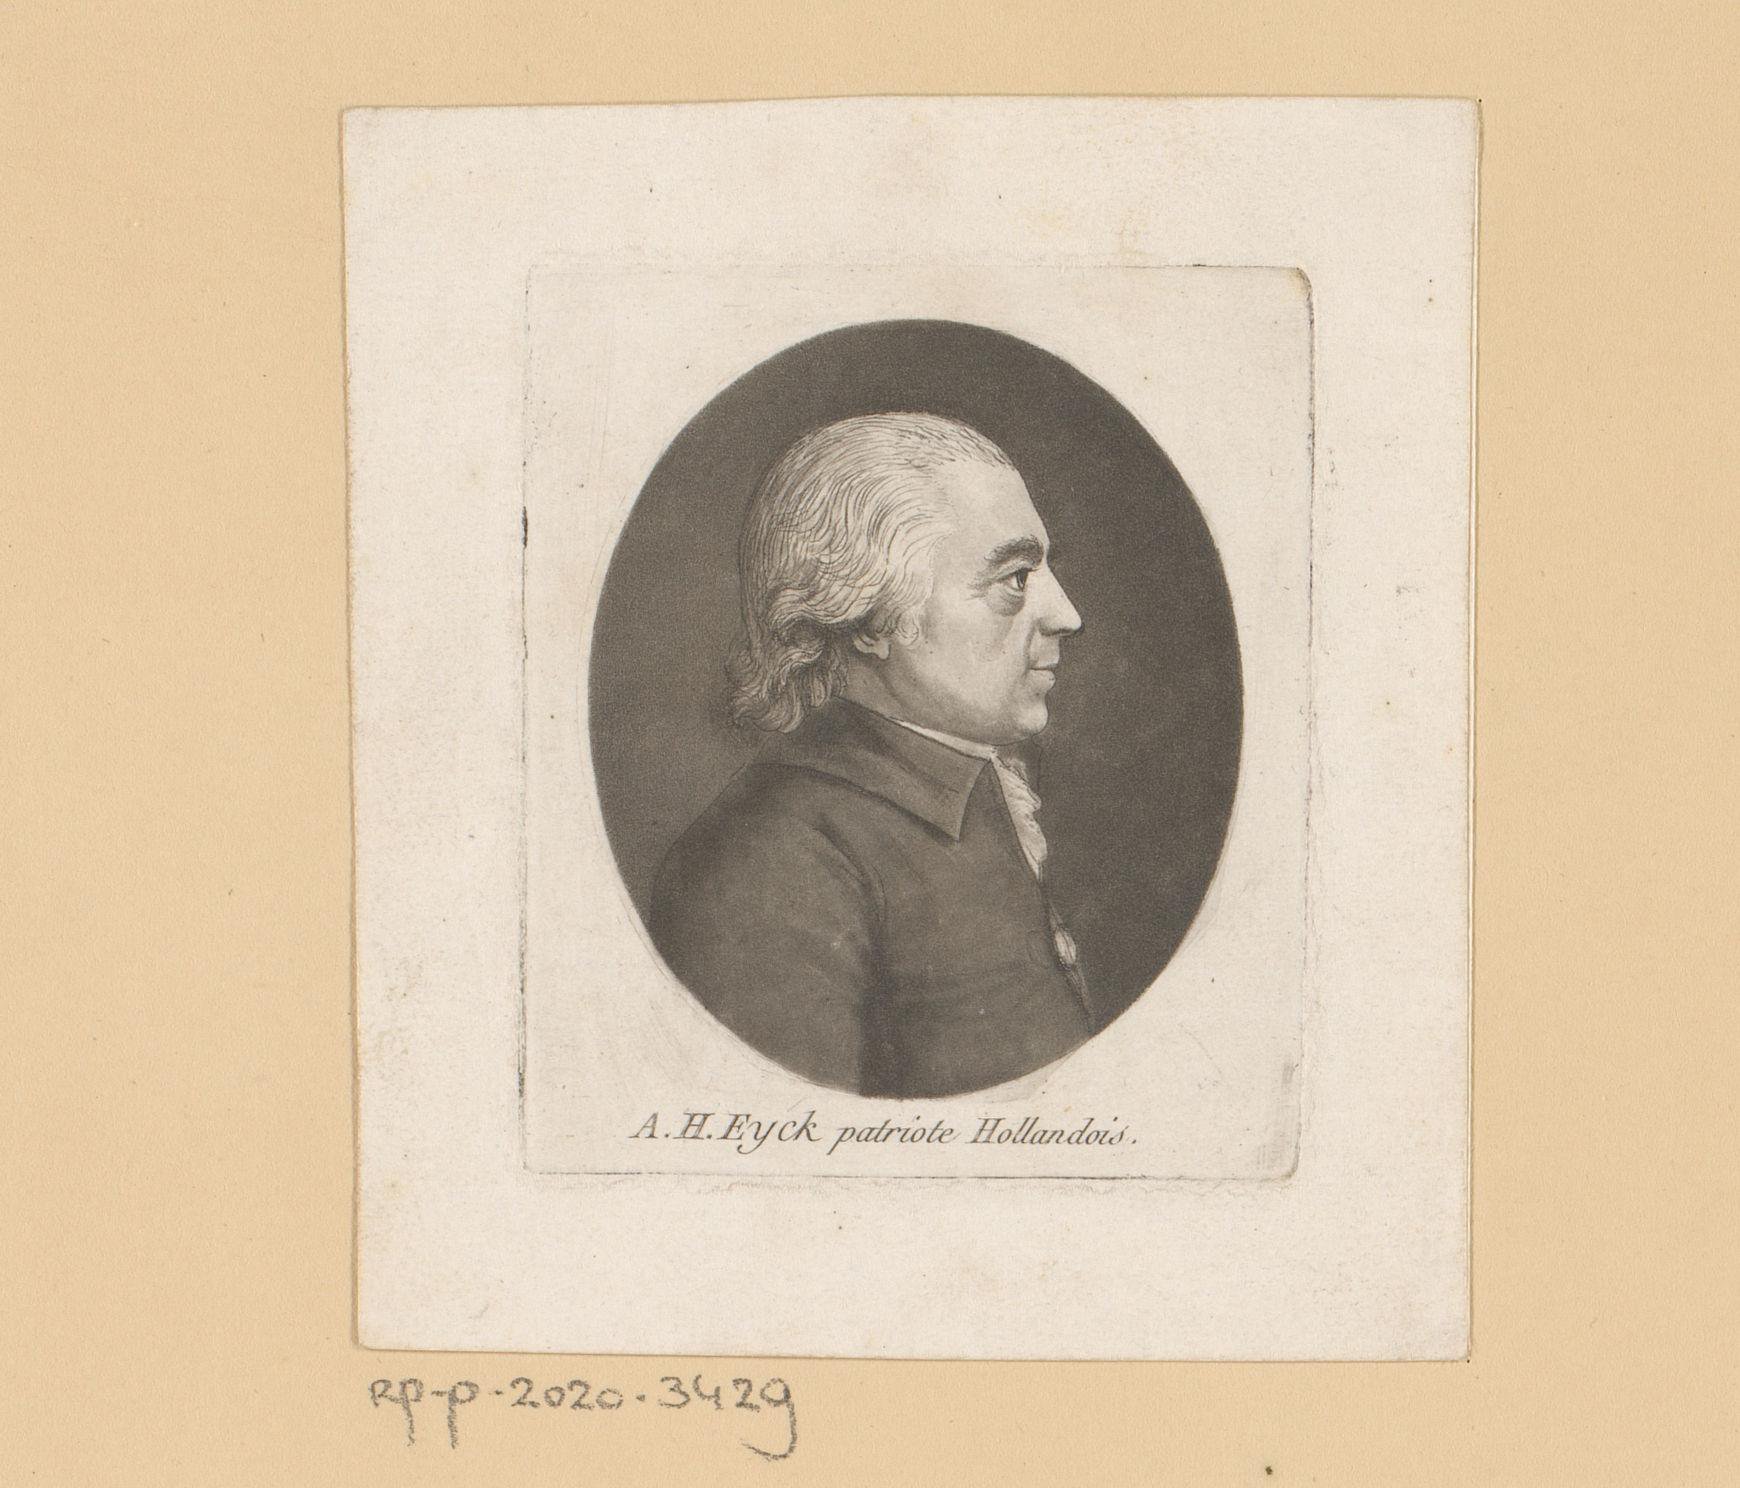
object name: physionotrace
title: A.H. Eyck patriote Hollandois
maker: edme quenedey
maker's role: print maker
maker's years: 1756-1830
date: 1785-1802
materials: paper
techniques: aquatint, etching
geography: paris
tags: mayor, silhouette-apparatus, 'physionotrace', historical persons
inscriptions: annotation: ‘Coll. Fr.’, collector's mark: Lugt 2227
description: Deze prent heeft het nummer M.98 in het fonds van Quenedey.